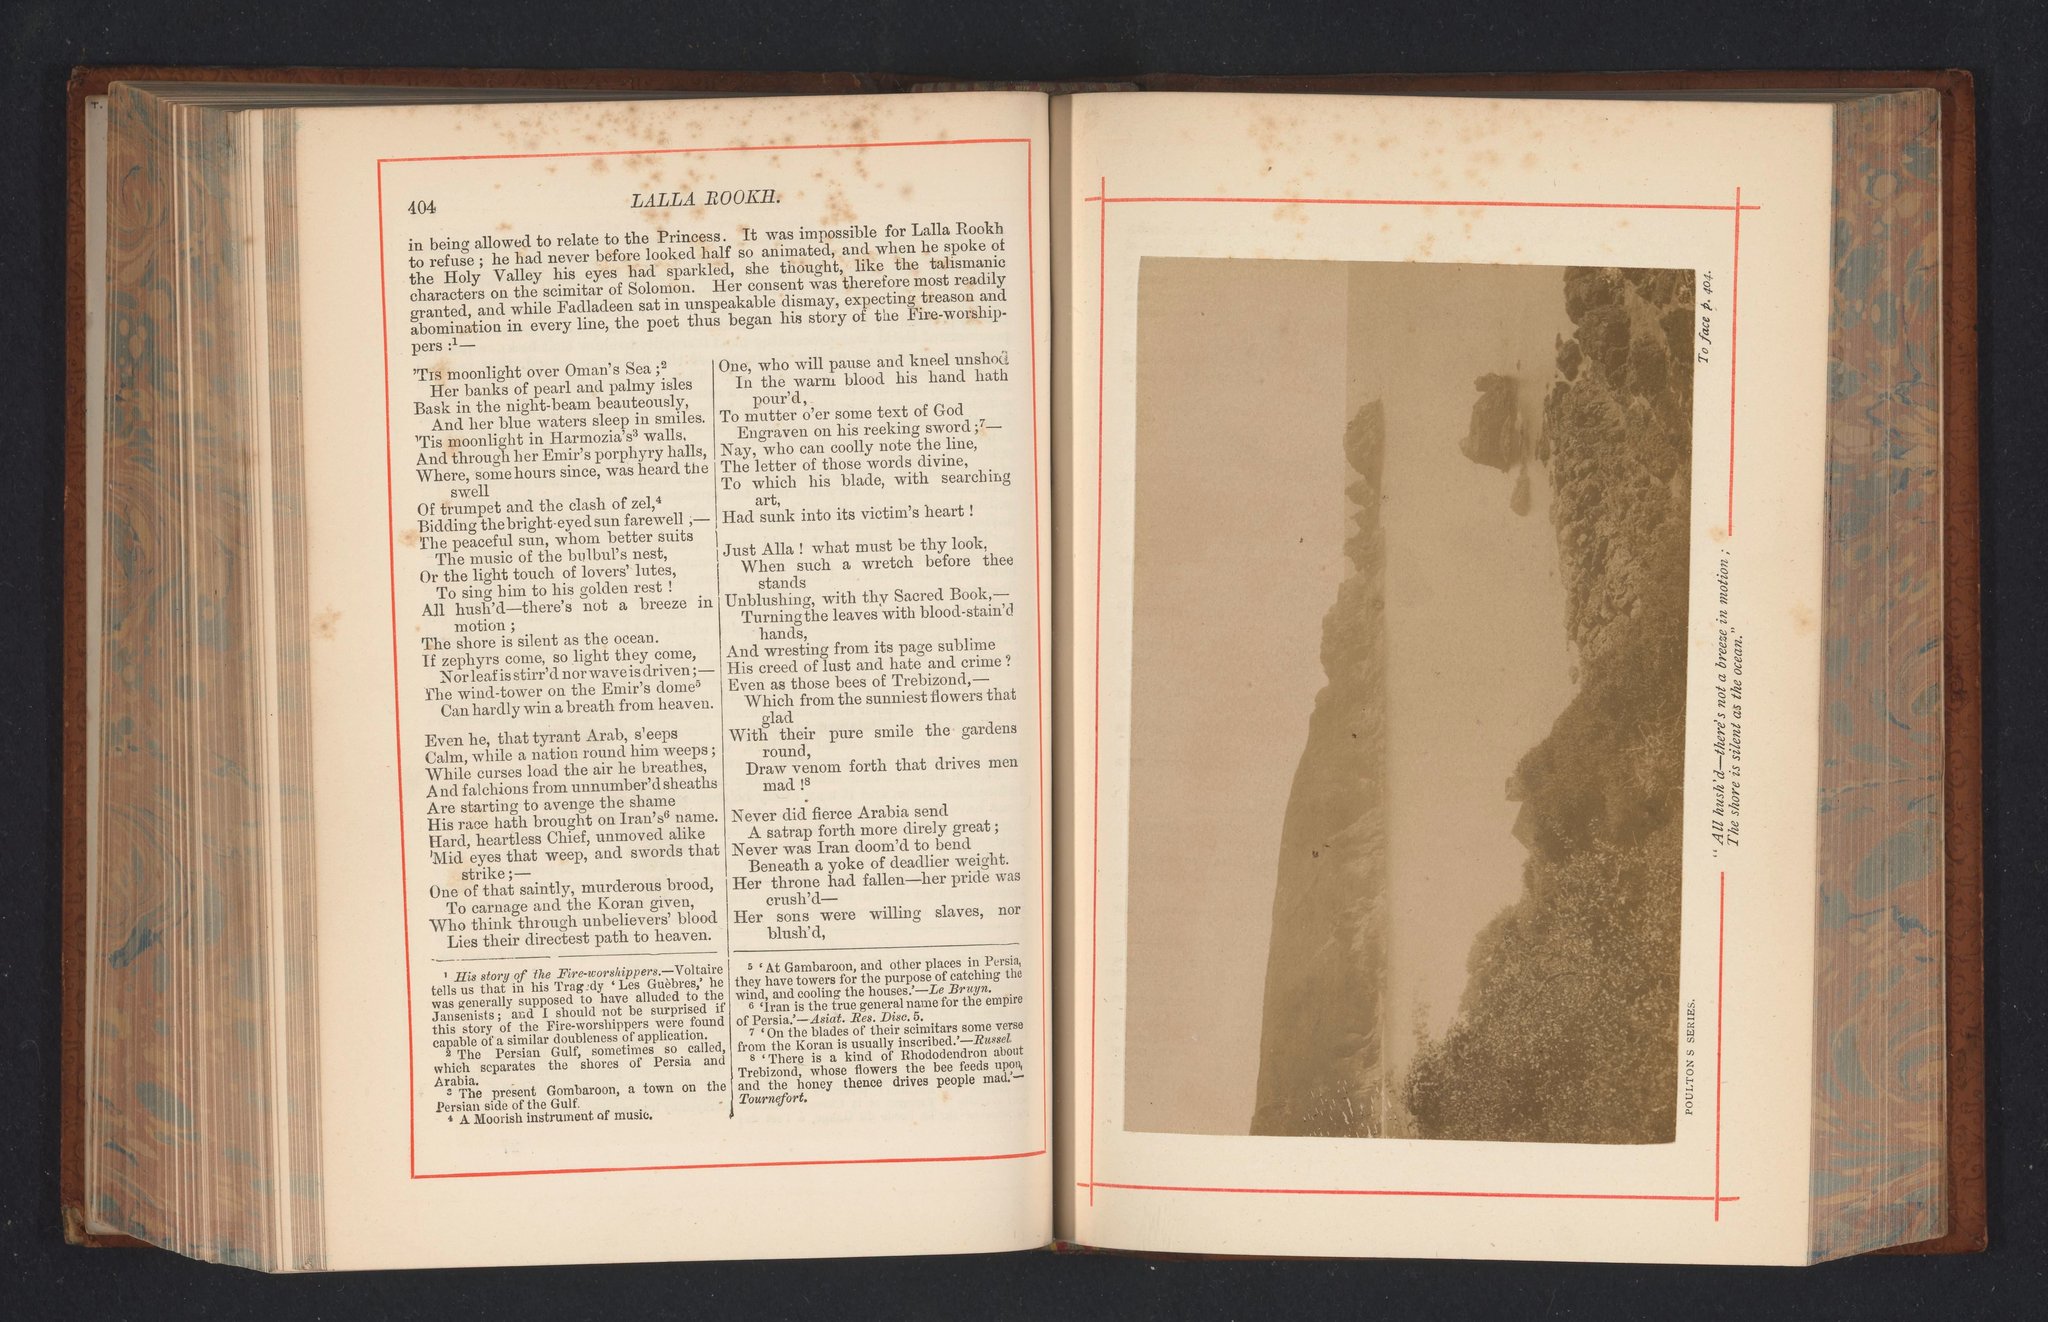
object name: page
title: Gezicht op een rotsachtige kust te Ierland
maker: Anonymous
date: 1882-1892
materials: photographic support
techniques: albumen print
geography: ireland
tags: rocky coast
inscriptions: inscription: ‘"All hush'd (...) the ocean."’